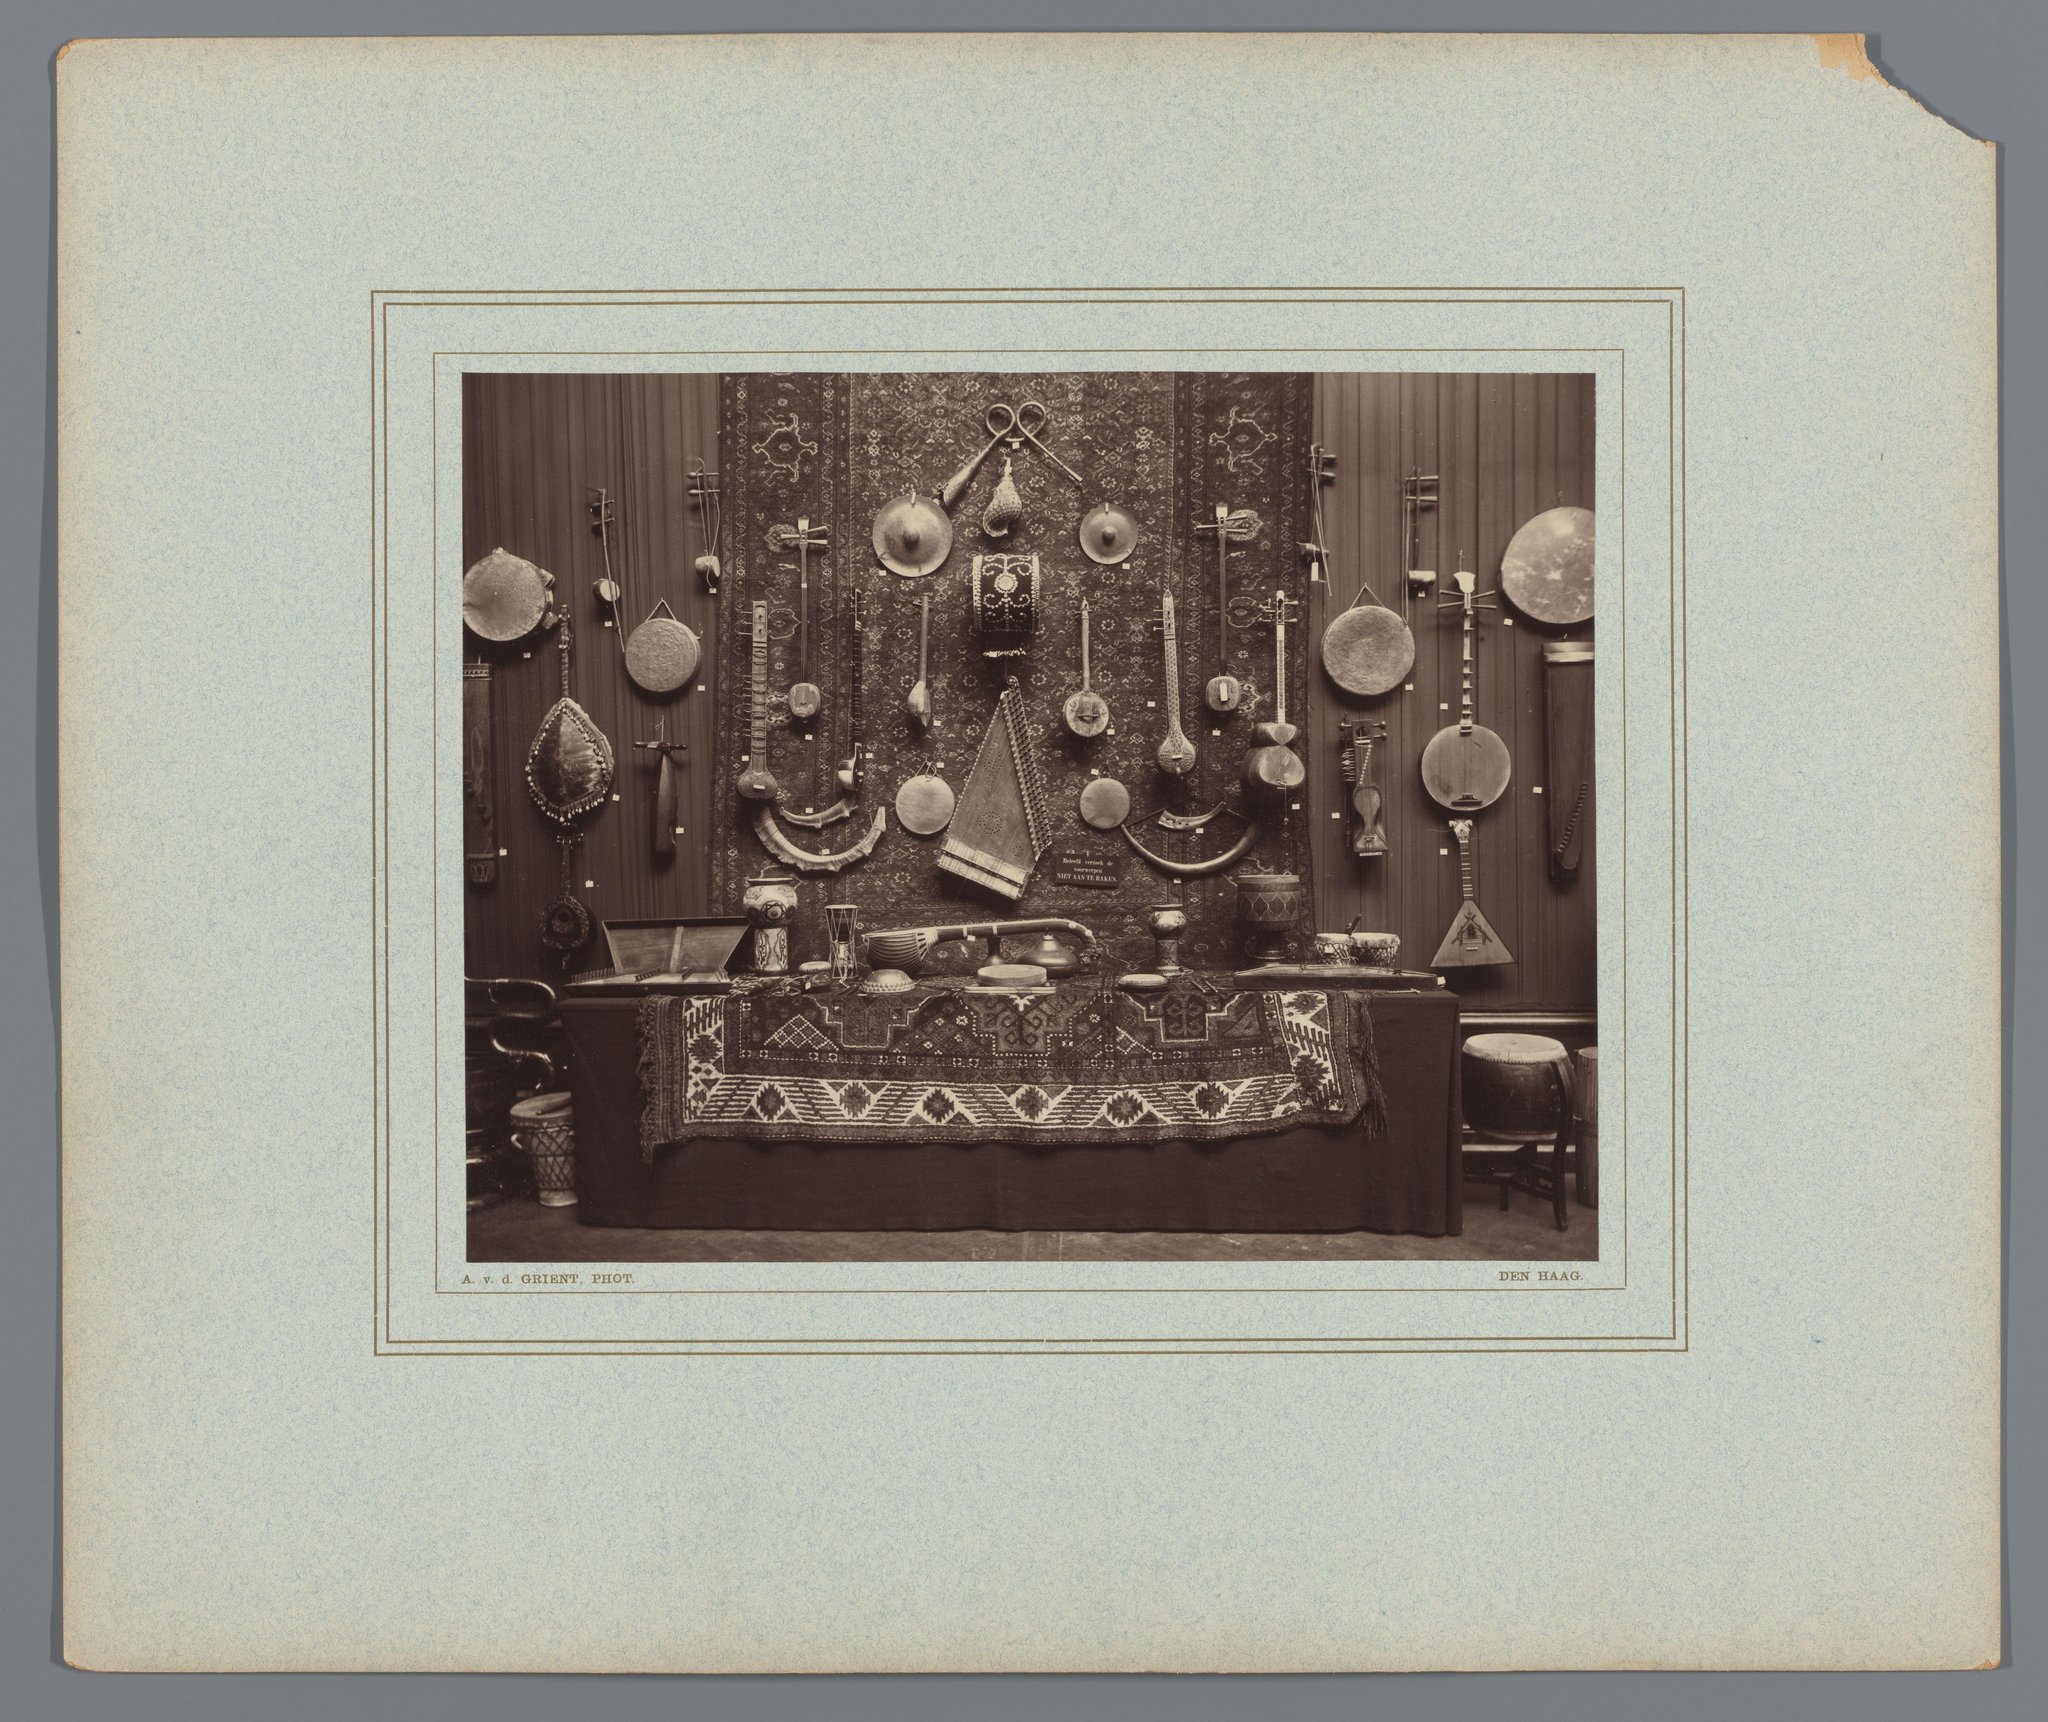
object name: photomechanical print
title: Muziekinstrumenten uit de collectie Daniël François Scheurleer, tentoongesteld in Pulchri Studio in 1893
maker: adrianus van der grient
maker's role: fotograaf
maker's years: 1858-1941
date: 1893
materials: cardboard, paper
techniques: woodburytype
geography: pulchri studio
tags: daniël françois lunsingh scheurleer, musical instruments; group of musical instruments, exhibition ~ art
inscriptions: inscription: ‘A. v. d. GRIENT, PHOT. - DEN HAAG.’